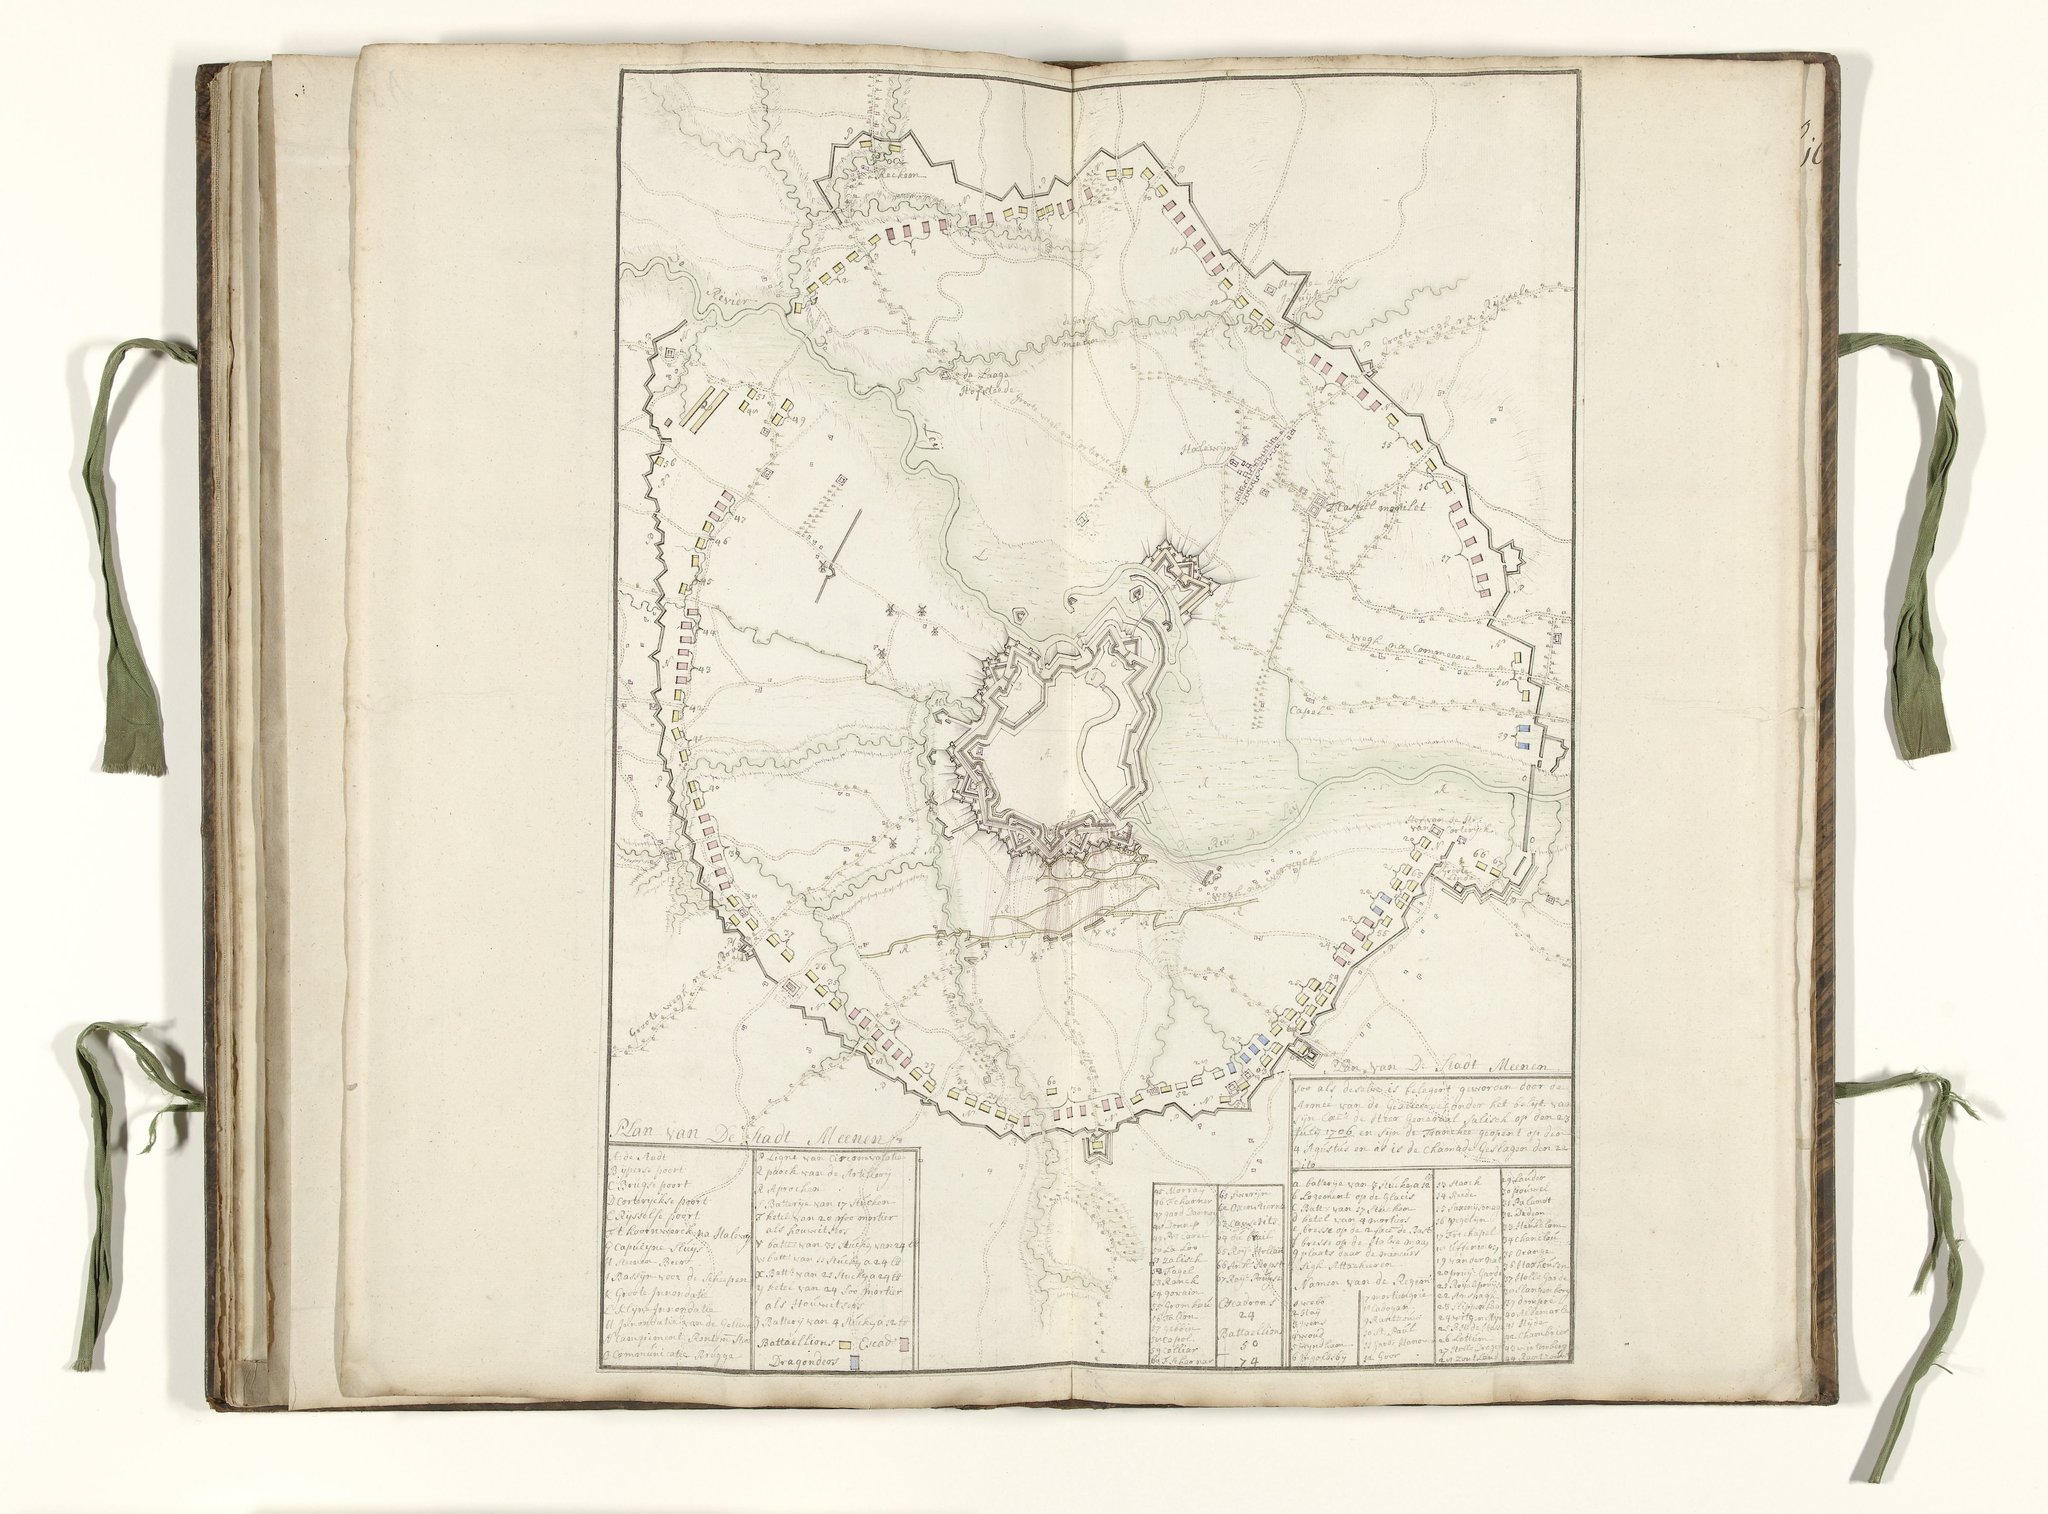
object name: map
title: Beleg van Menen, 1706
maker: samuel du ry de champdoré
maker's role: draughtsman, engineer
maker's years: 1651-1729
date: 1706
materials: paper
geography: netherlands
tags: siege, position war, maps of cities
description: Plattegrond van het beleg van de versterkte stad Menen door de Geallieerden onder Von Salisch, aangevangen op 23 juli, ingenomen op 22 augustus 1706. Onderaan de legenda's A-Z, a-g en 1-67 in het Nederlands. Bij de kaart twee losse bladen met een tabel van de aantallen doden en gewonden gevallen bij de inname van Menen en een Memoire op een gevouwen blad. Onderdeel van een verzameling getekende plannen van versterkte plaatsen in Nederland en omringende landen ten tijde van de Spaanse Successieoorlog (deel C).